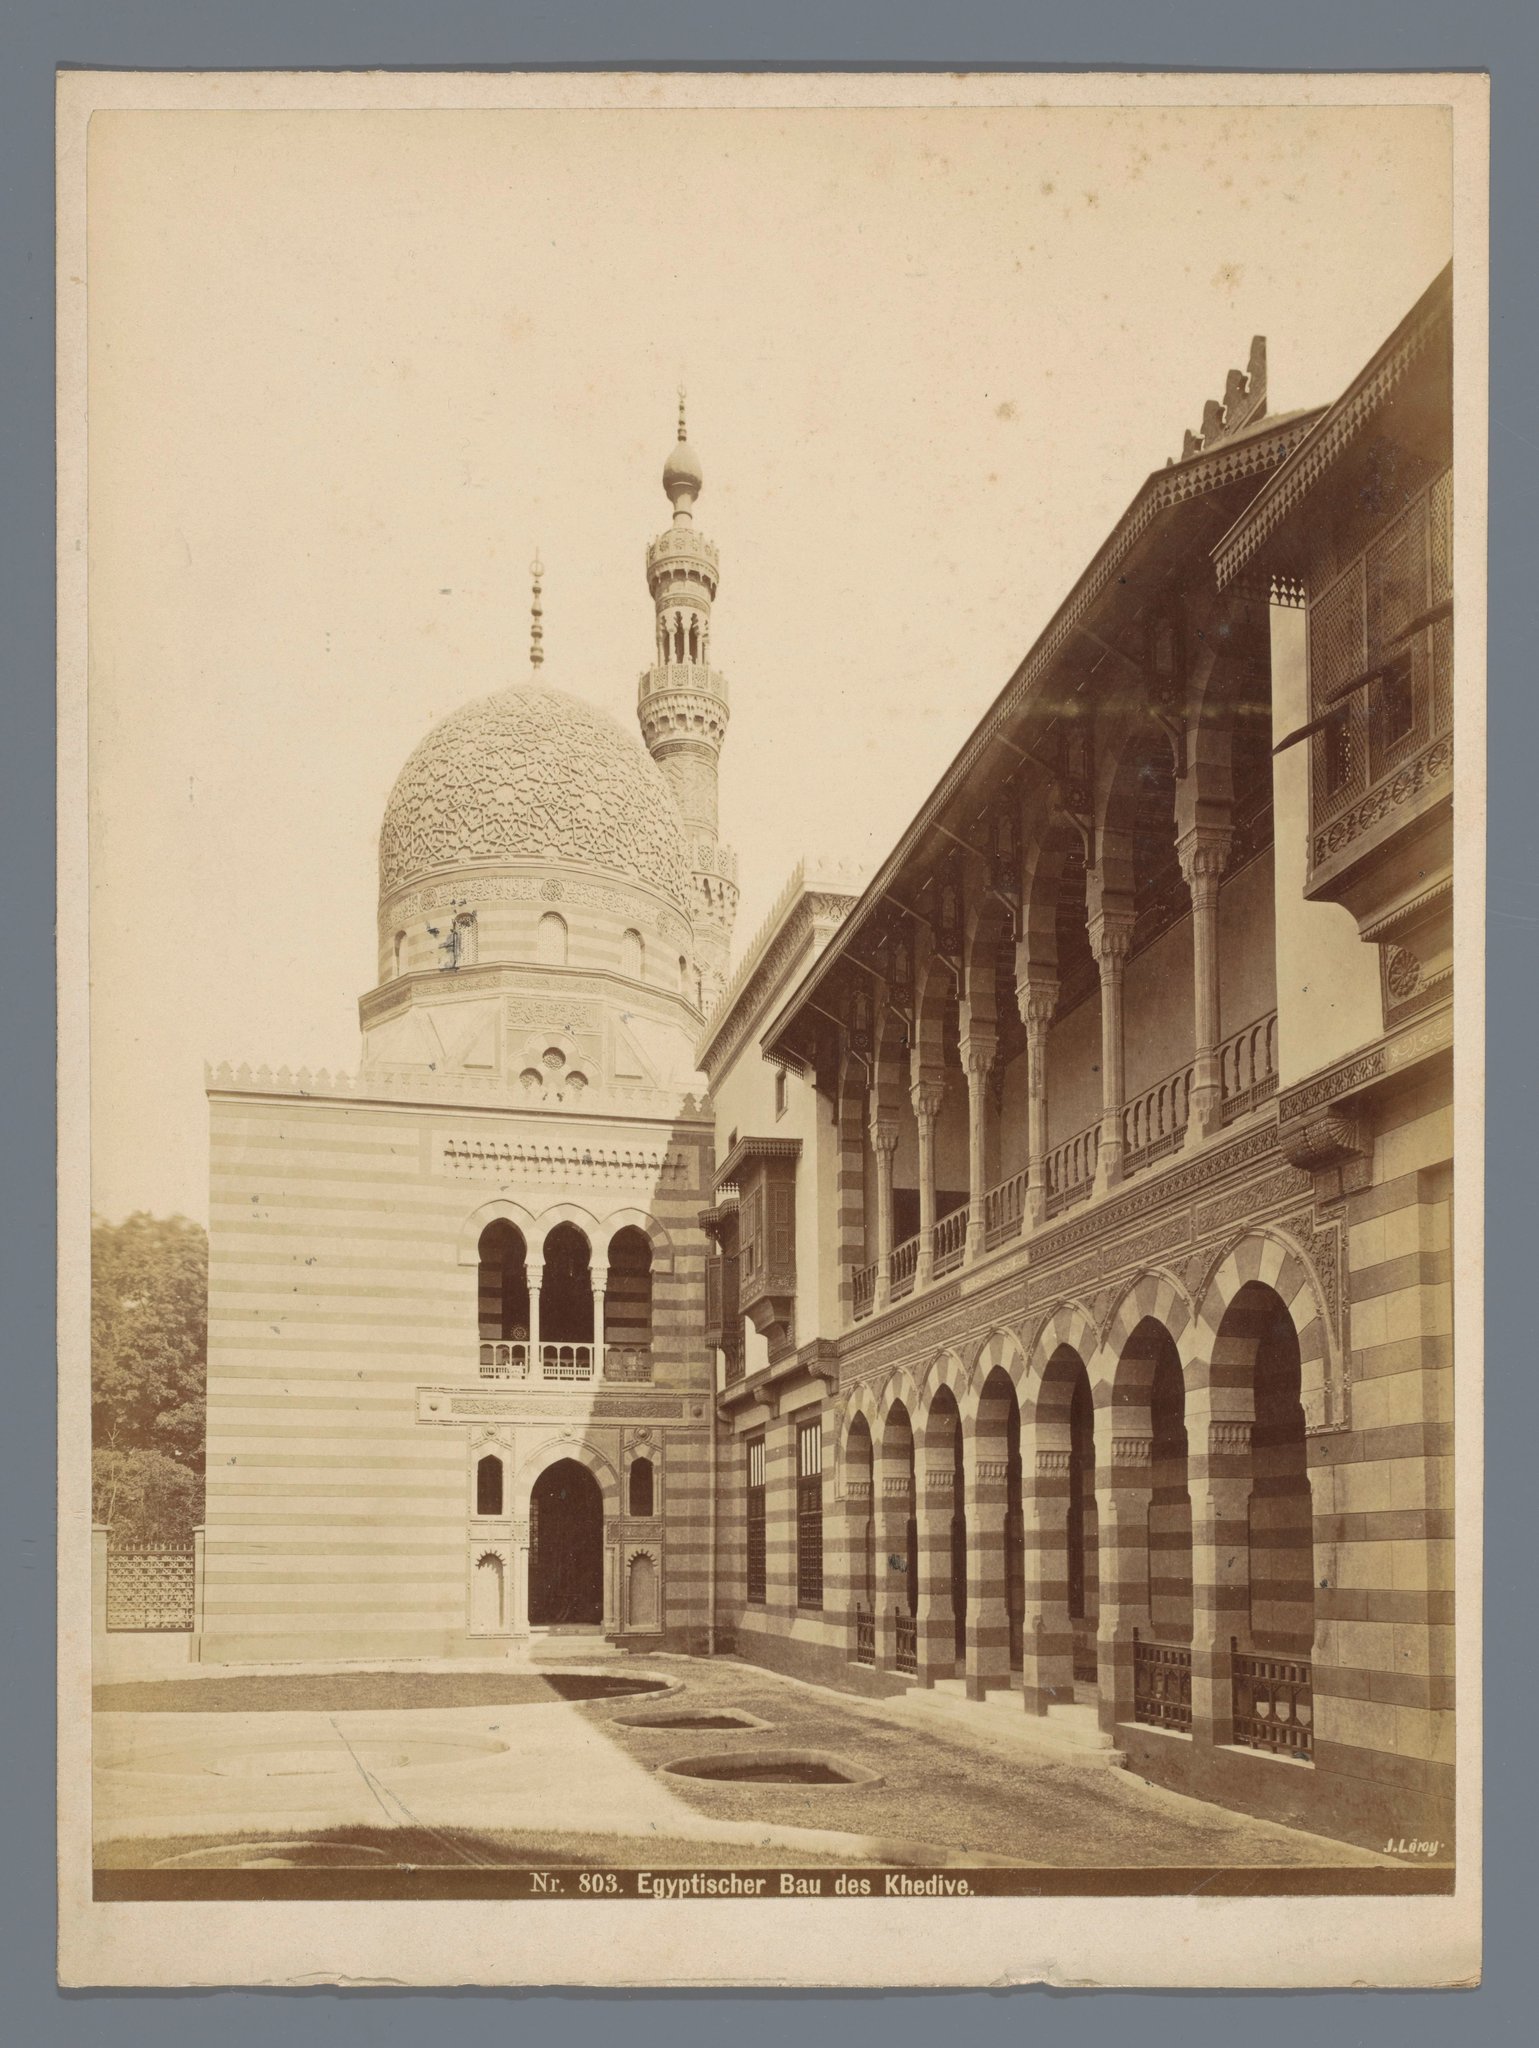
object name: photograph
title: Gebouw van de Kedive van Egypte te Caïro, Egypte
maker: j. loroy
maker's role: fotograaf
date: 1867-1914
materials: cardboard, paper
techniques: albumen print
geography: cairo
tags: exterior ~ representation of a building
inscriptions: inscription: ‘Egypte’, number: ‘Nr. 803.’